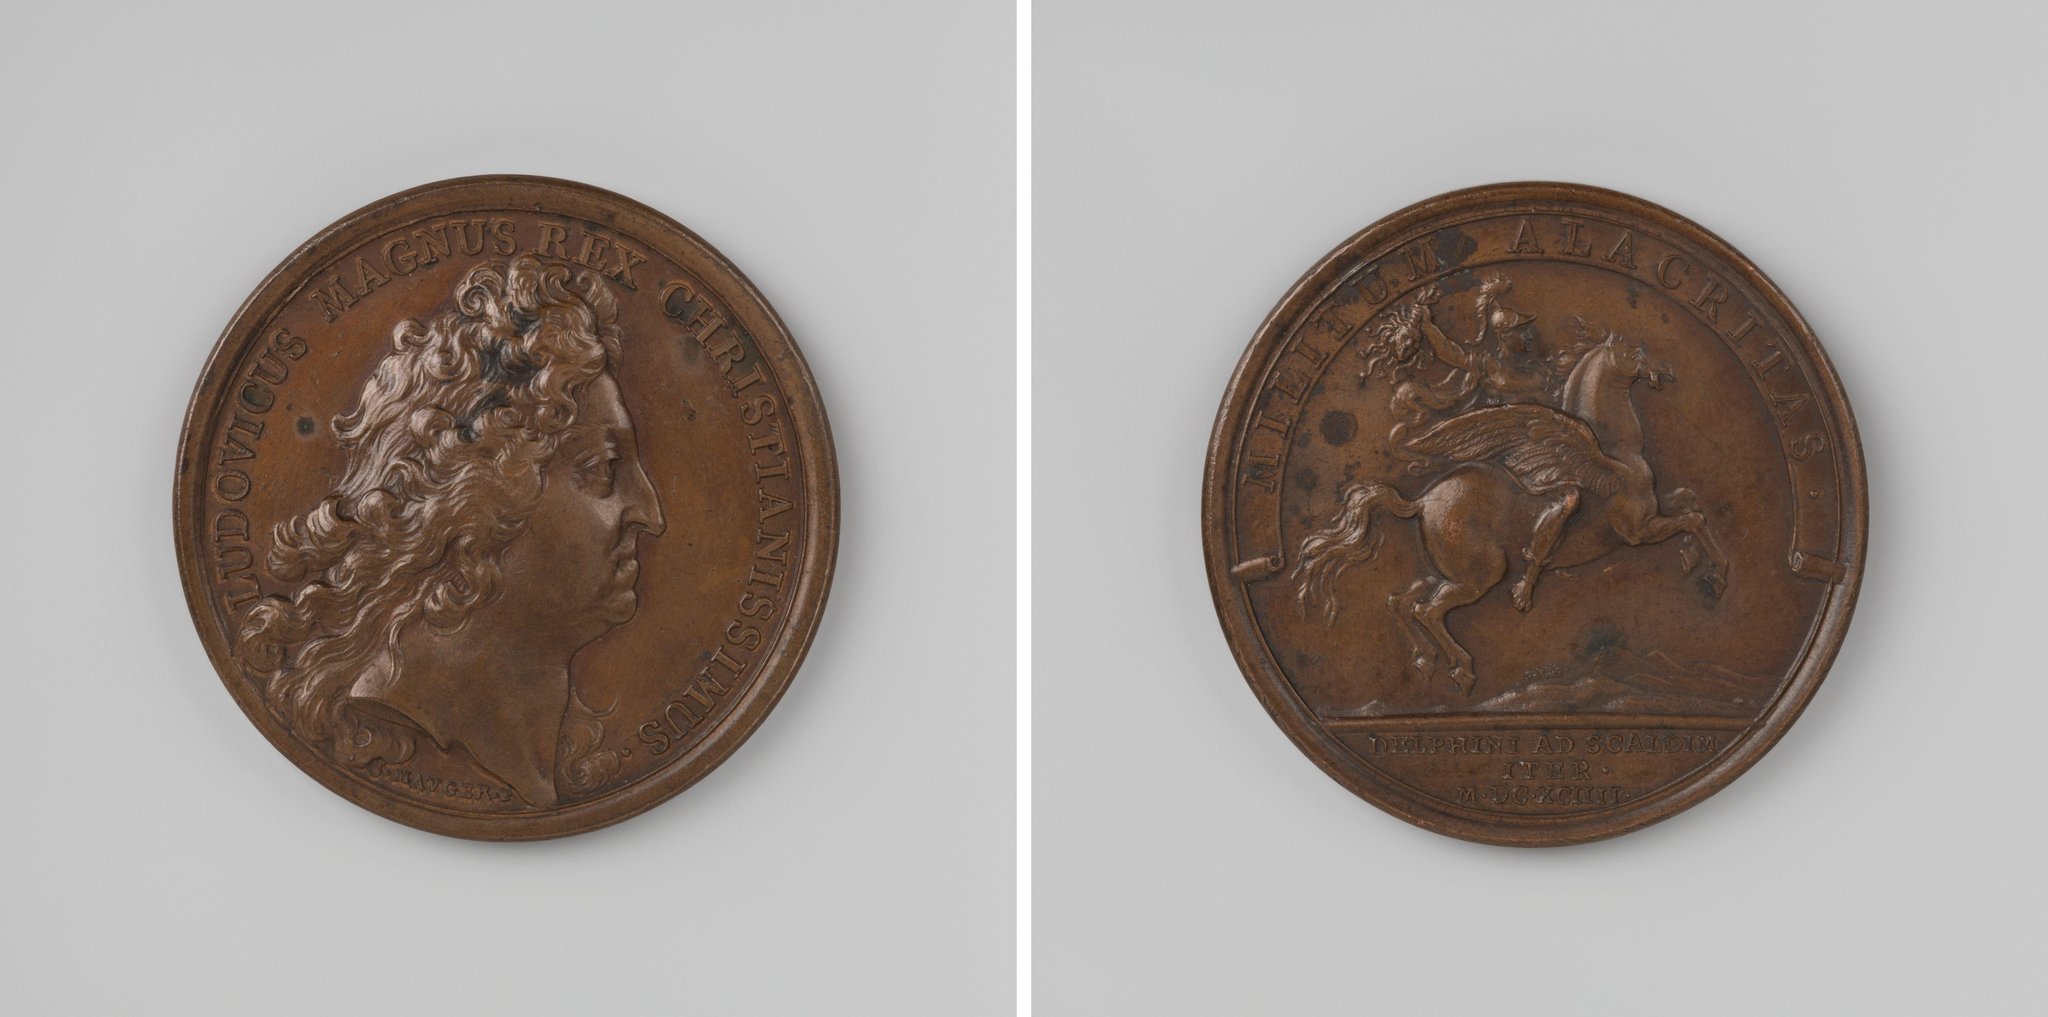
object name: history medal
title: Tocht van de Dauphin naar de Schelde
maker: jean mauger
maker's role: medailleur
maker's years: 1648-1722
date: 1699-1703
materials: bronze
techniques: striking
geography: paris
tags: lodewijk xiv (koning van frankrijk), dauphin van frankrijk lodewijk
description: Bronzen penning. Voorzijde: borststuk man binnen omschrift. Keerzijde: Perseus zittende op het gevleugelde paard Pegasus houdt het hoofd van Medusa in zijn hand binnen omschrift; afsnede: opschrift